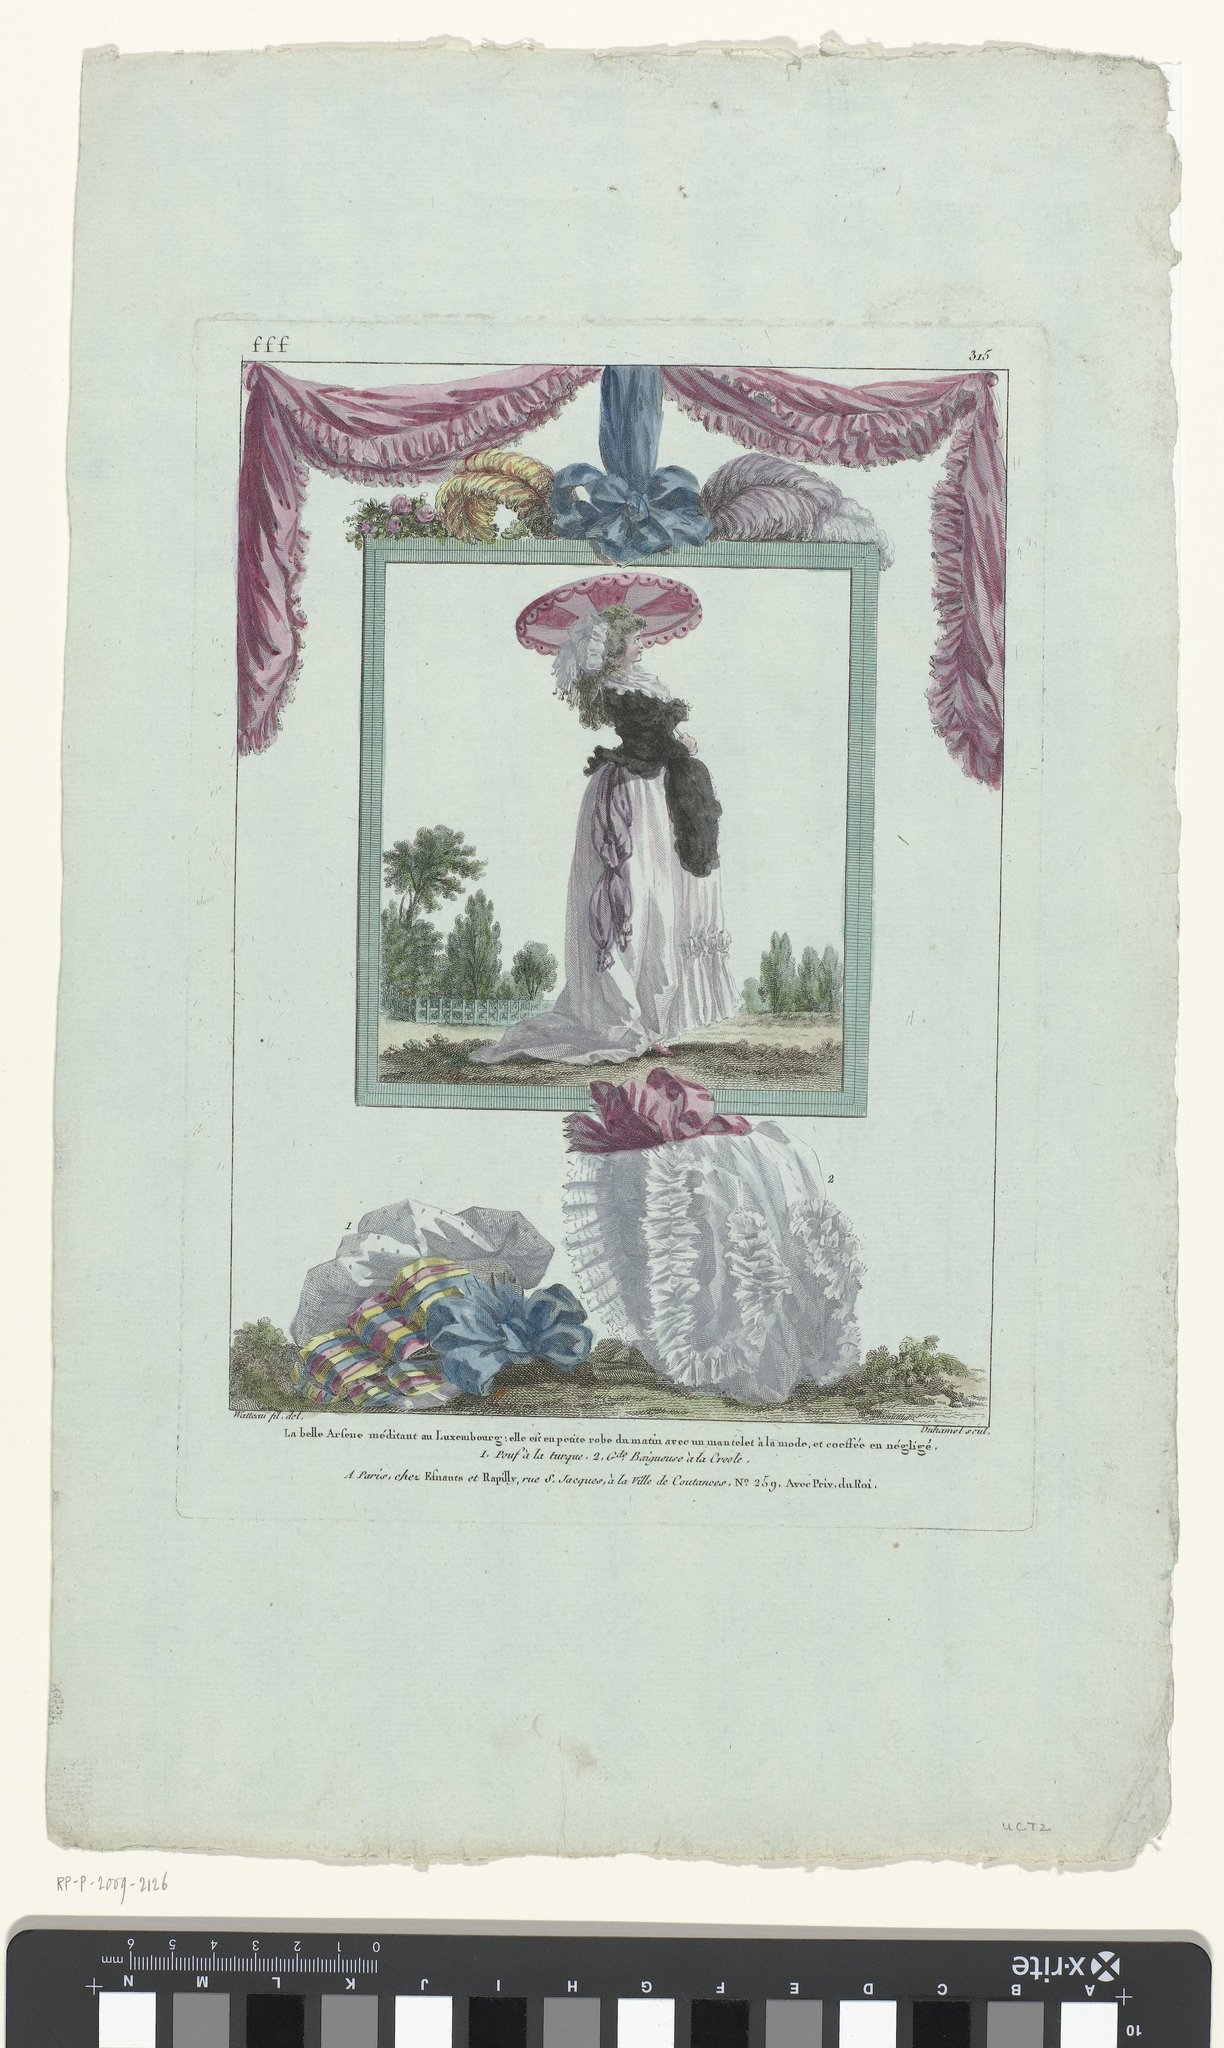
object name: fashion print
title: Gallerie des Modes et Costumes Français, 1786, fff 315 : La belle Arsèn (...)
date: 1786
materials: paper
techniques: engraving, hand coloring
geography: paris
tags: head-gear (pouf) (+ women's clothes), dress, gown: morning dress (+ women's clothes), clothing for the upper part of the body (mantelet) (+ women's clothes), head-gear (baigneuse) (+ women's clothes), head-gear: cap (+ women's clothes), fashion plates, bow (ornamental part of clothing), parasol, sunshade (+ women's clothes)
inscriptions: address: ‘A Paris, chez Esnauts et Rapilly, rue S. Jacques, à la Ville de Coutances, No. 259. Avec Priv. du Roi.’, caption: ‘La belle Arsène méditant au Luxembourg: elle est en petite robe du matin avec un mantelet à la mode, et coeffée en négligé. / 1. Pouf à la tuque. 2. G.de Baigneuse à la Creole.’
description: Volgens het onderschrift is de mooie Arsene aan het wandelen in de Jardin du Luxembourg. Zij draagt een eenvoudige ochtendjapon met een modieuze mantelet (kleine schoudermantel). Het kapsel 'en négligé'. Gestreepte parasol in de hand. Nummer 1: 'Pouf à la turque'. Nummer 2: 'Baigneuse à la Creole'. Uit serie fff. 50e Cahier de Costumes Français, 44e Suite d'Habillements à la mode en 1786, Gallerie des Modes et Costumes Français.